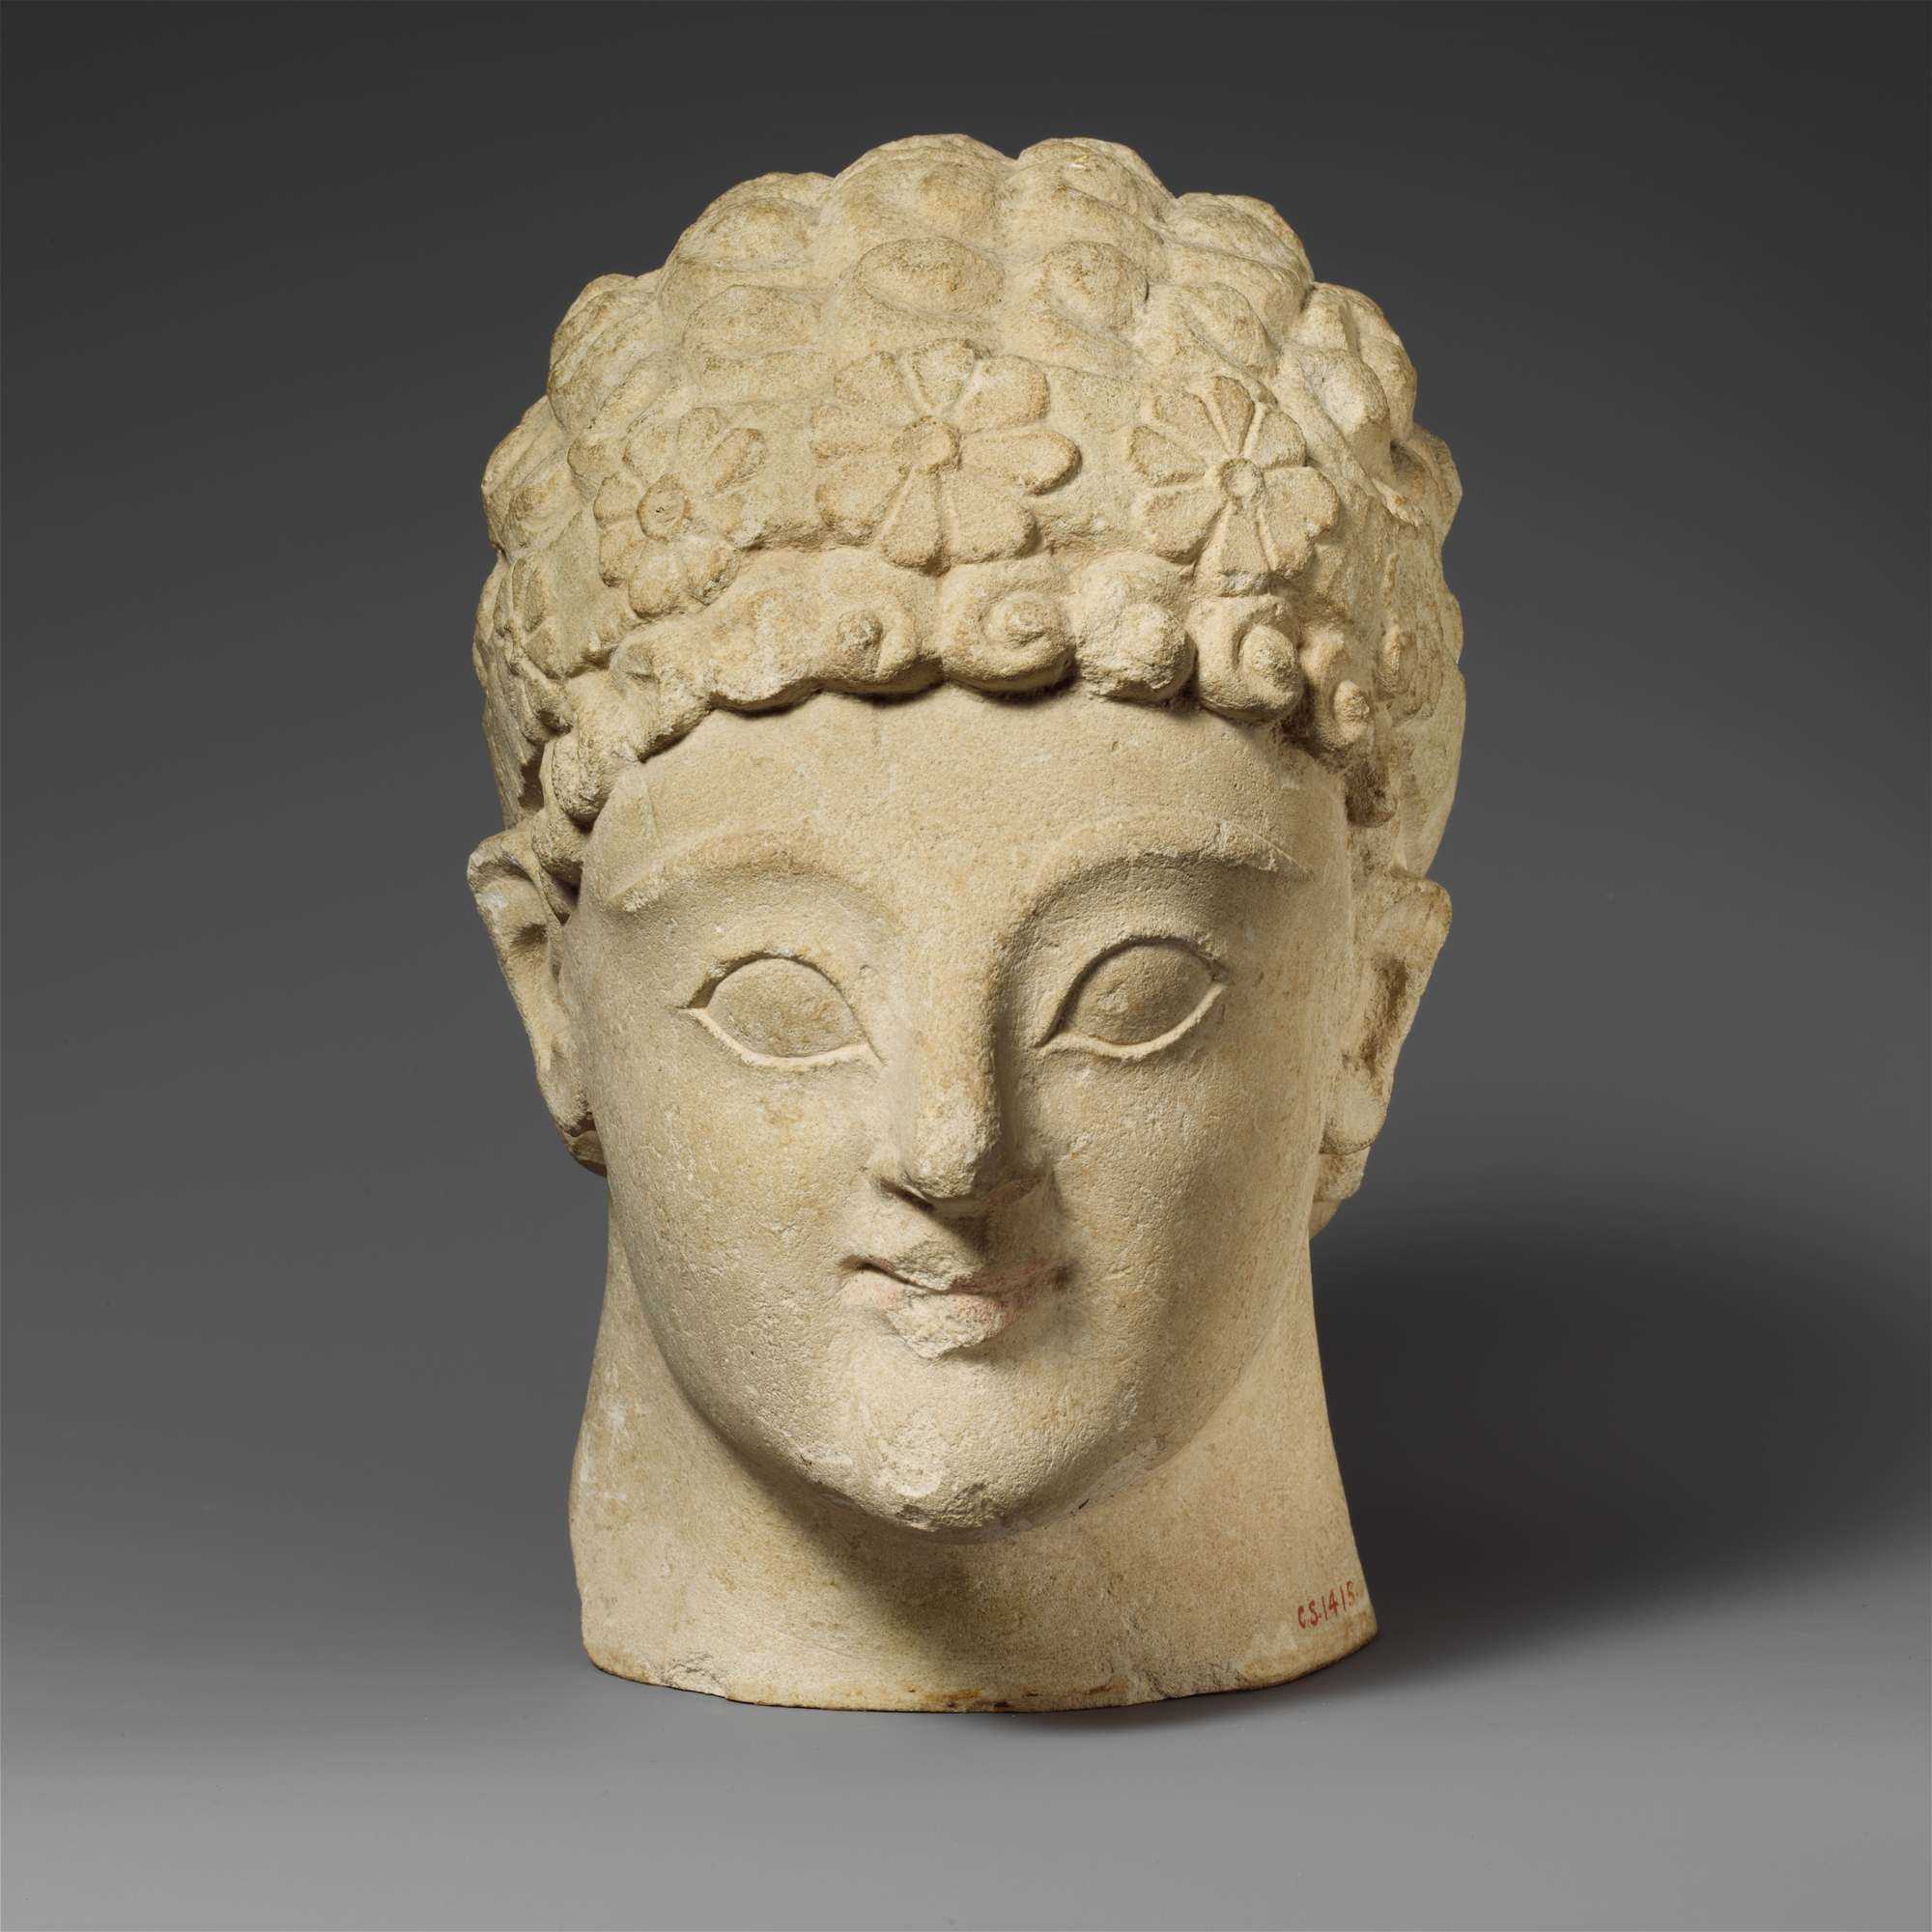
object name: head of a boy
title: Limestone head of a beardless male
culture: cypriot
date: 500-468 BCE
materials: limestone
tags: heads,men